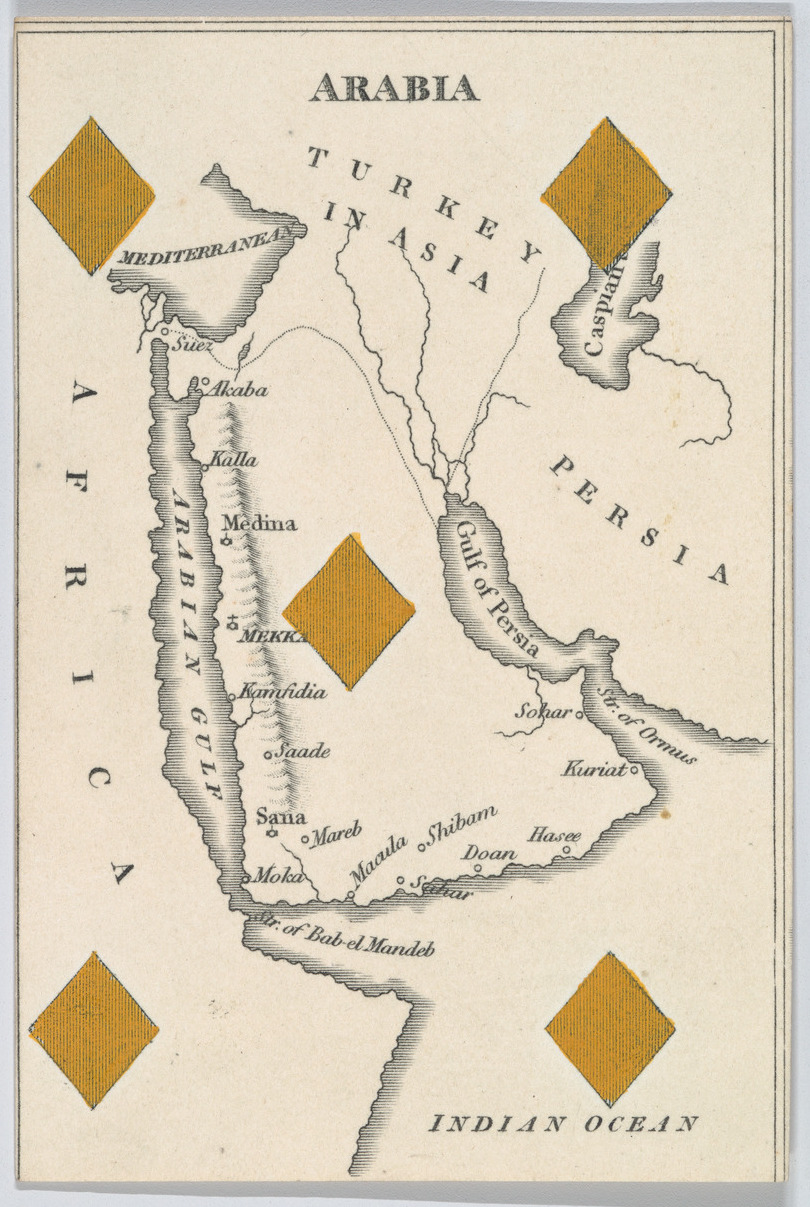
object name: print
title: Arabia, from "Court Game of Geography"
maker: william and henry rock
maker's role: publisher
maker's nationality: british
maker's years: 1821-1884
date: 1838-1855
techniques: engraving, hand coloring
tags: playing cards,maps